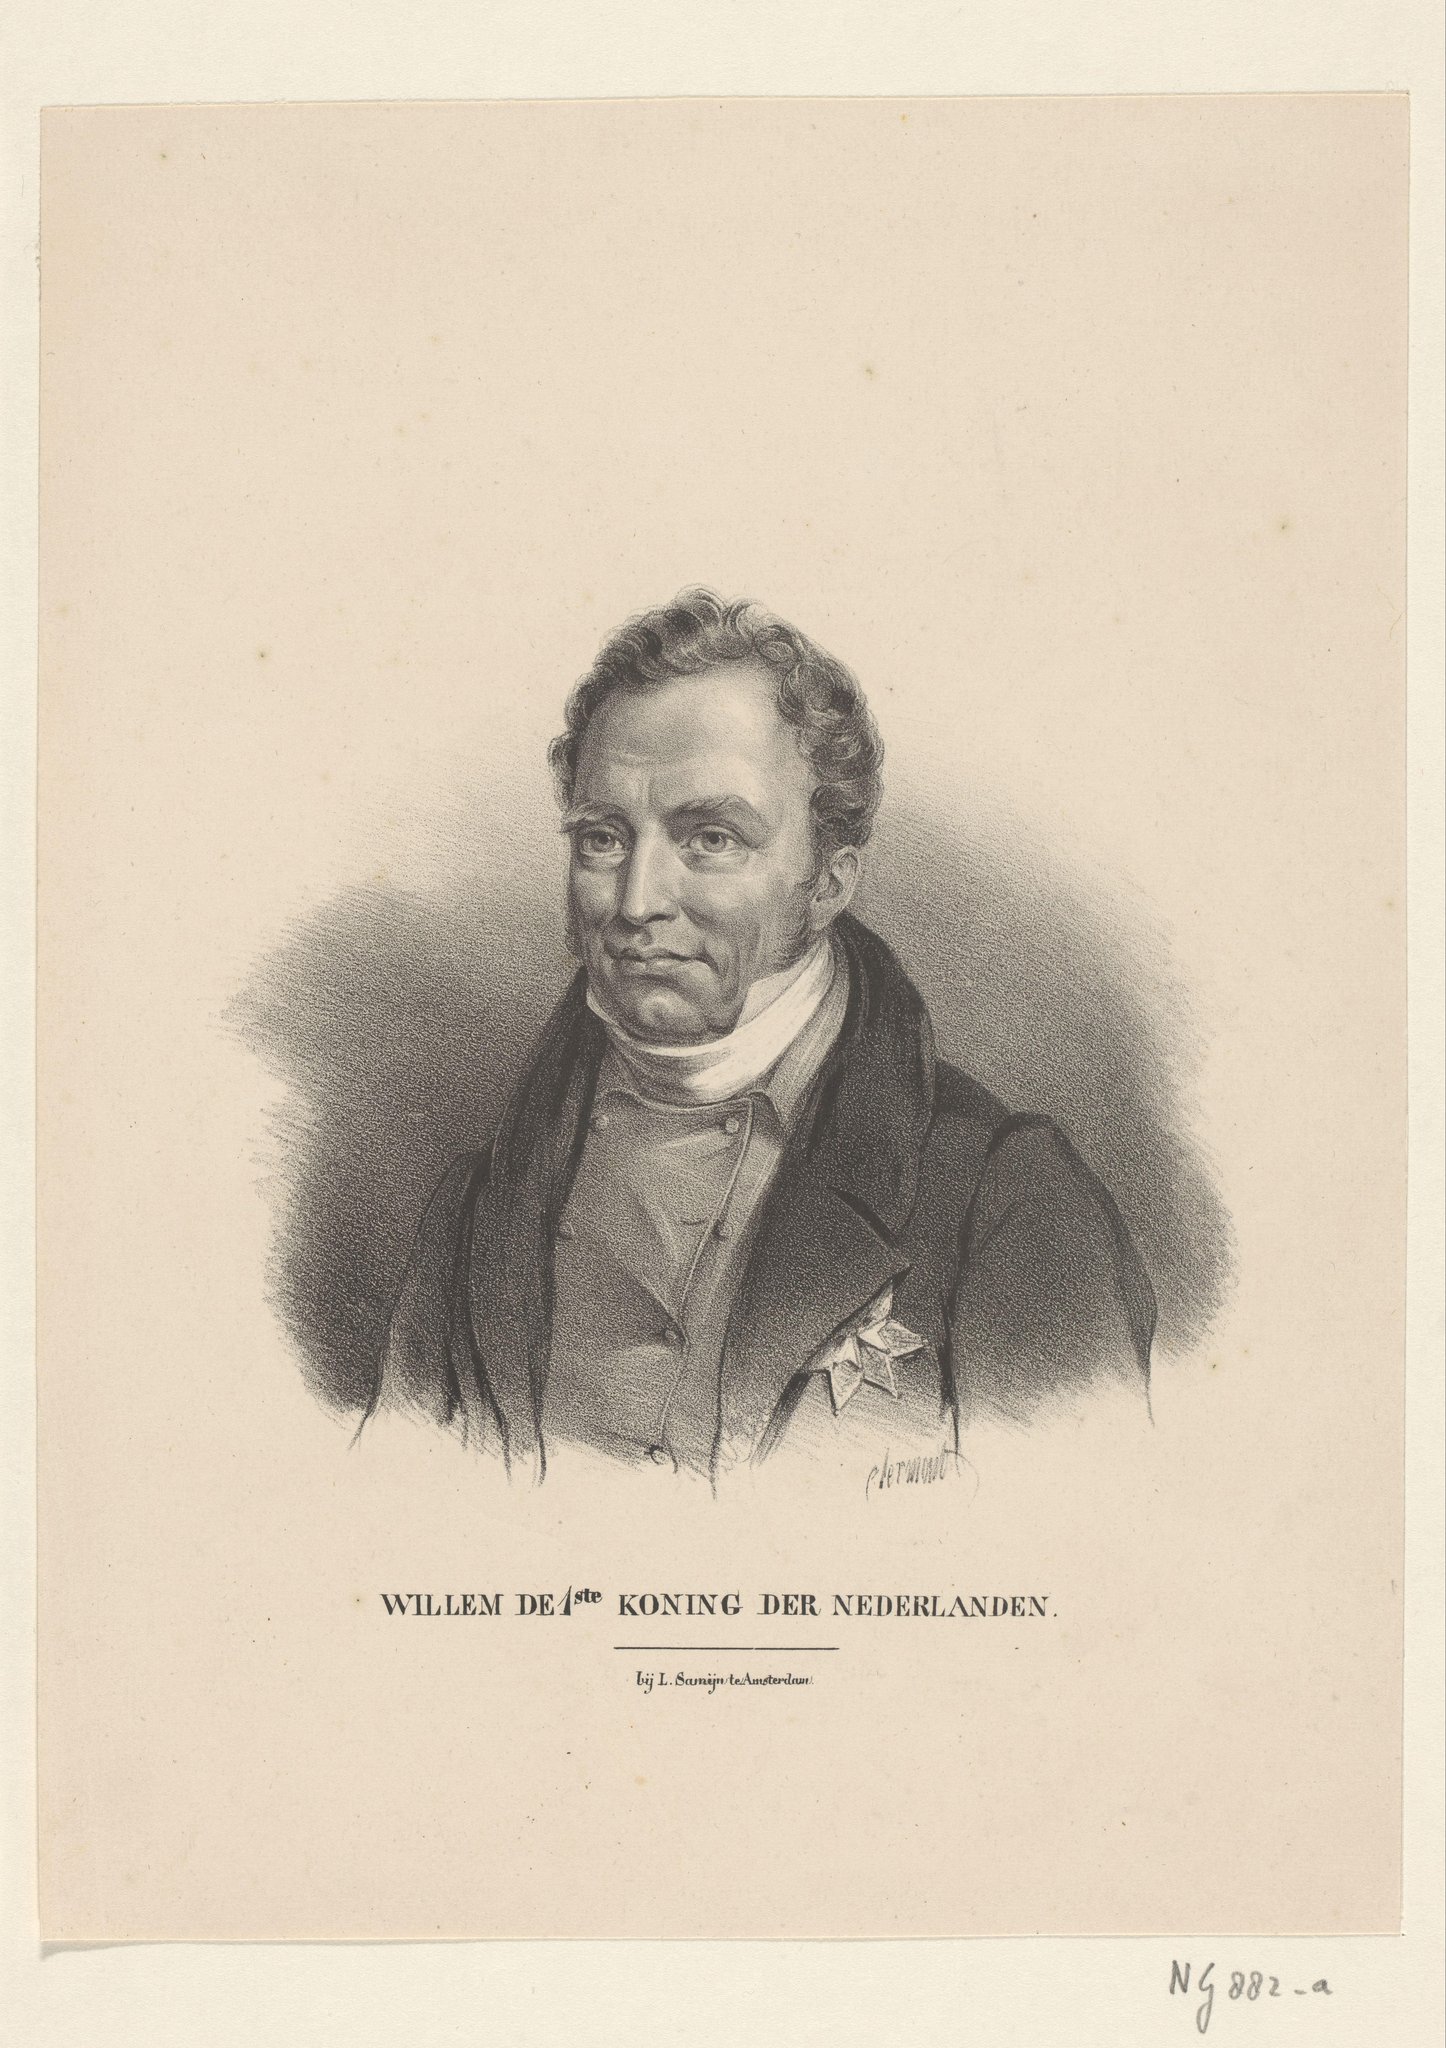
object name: print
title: Portret van koning Willem |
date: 1833-1836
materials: paper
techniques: lithograph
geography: amsterdam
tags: the hague, berlin, william i of the netherlands, historical persons, king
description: Portret van koning Willem I. Buste naar links.